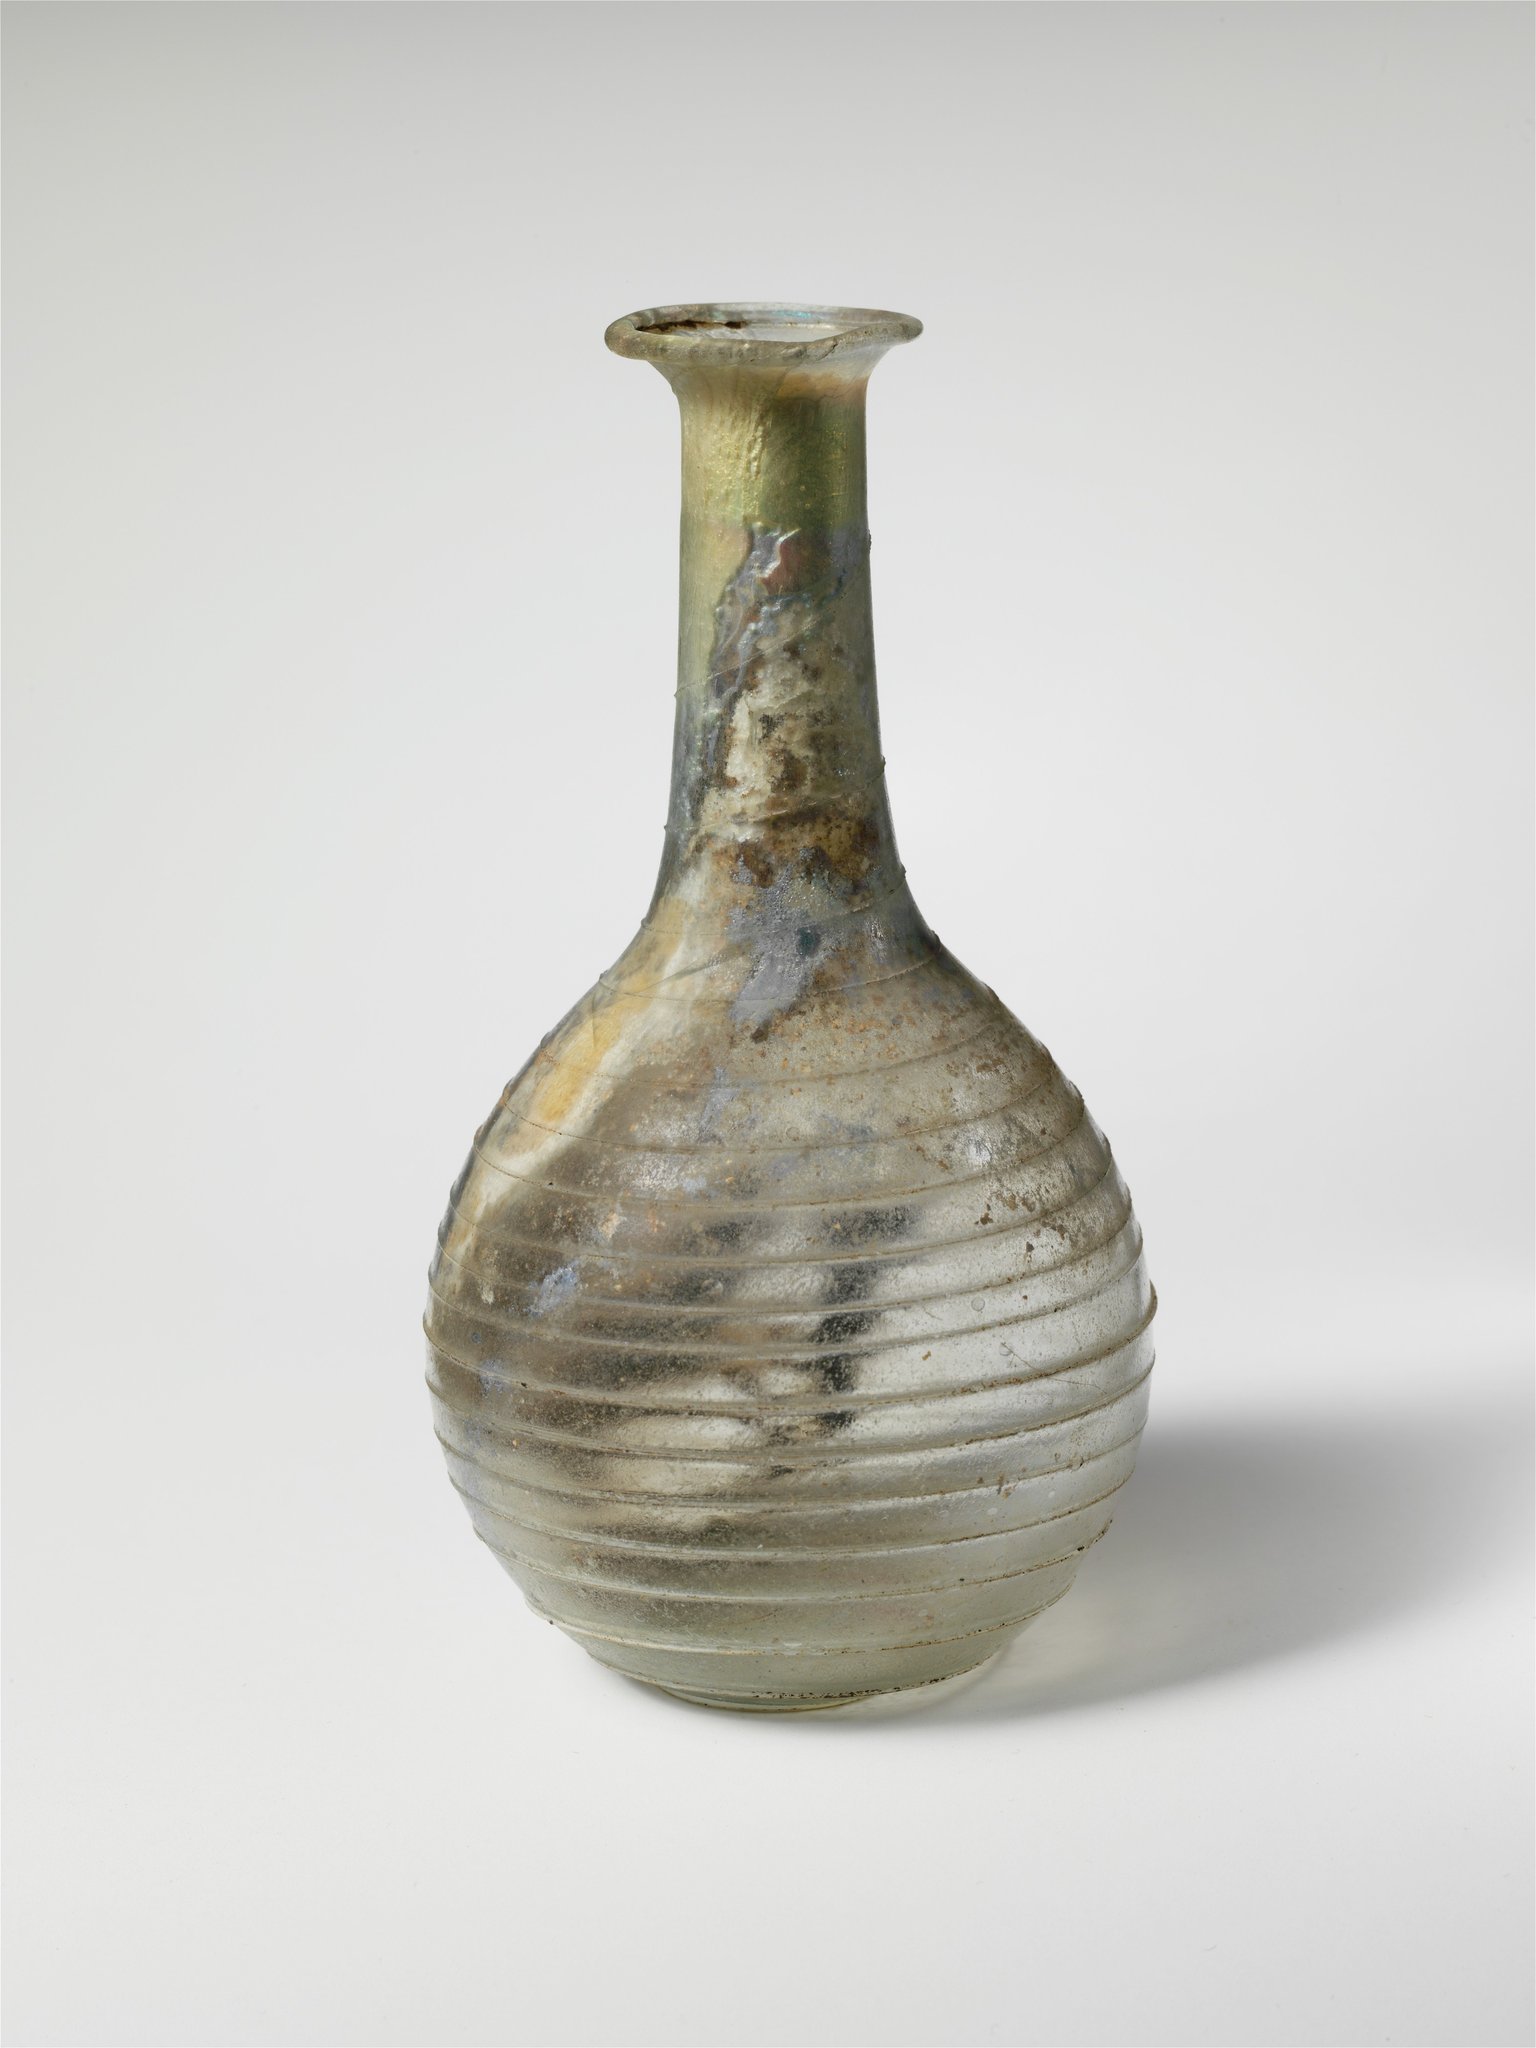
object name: perfume bottle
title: Glass perfume bottle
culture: roman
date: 1-100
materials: glass